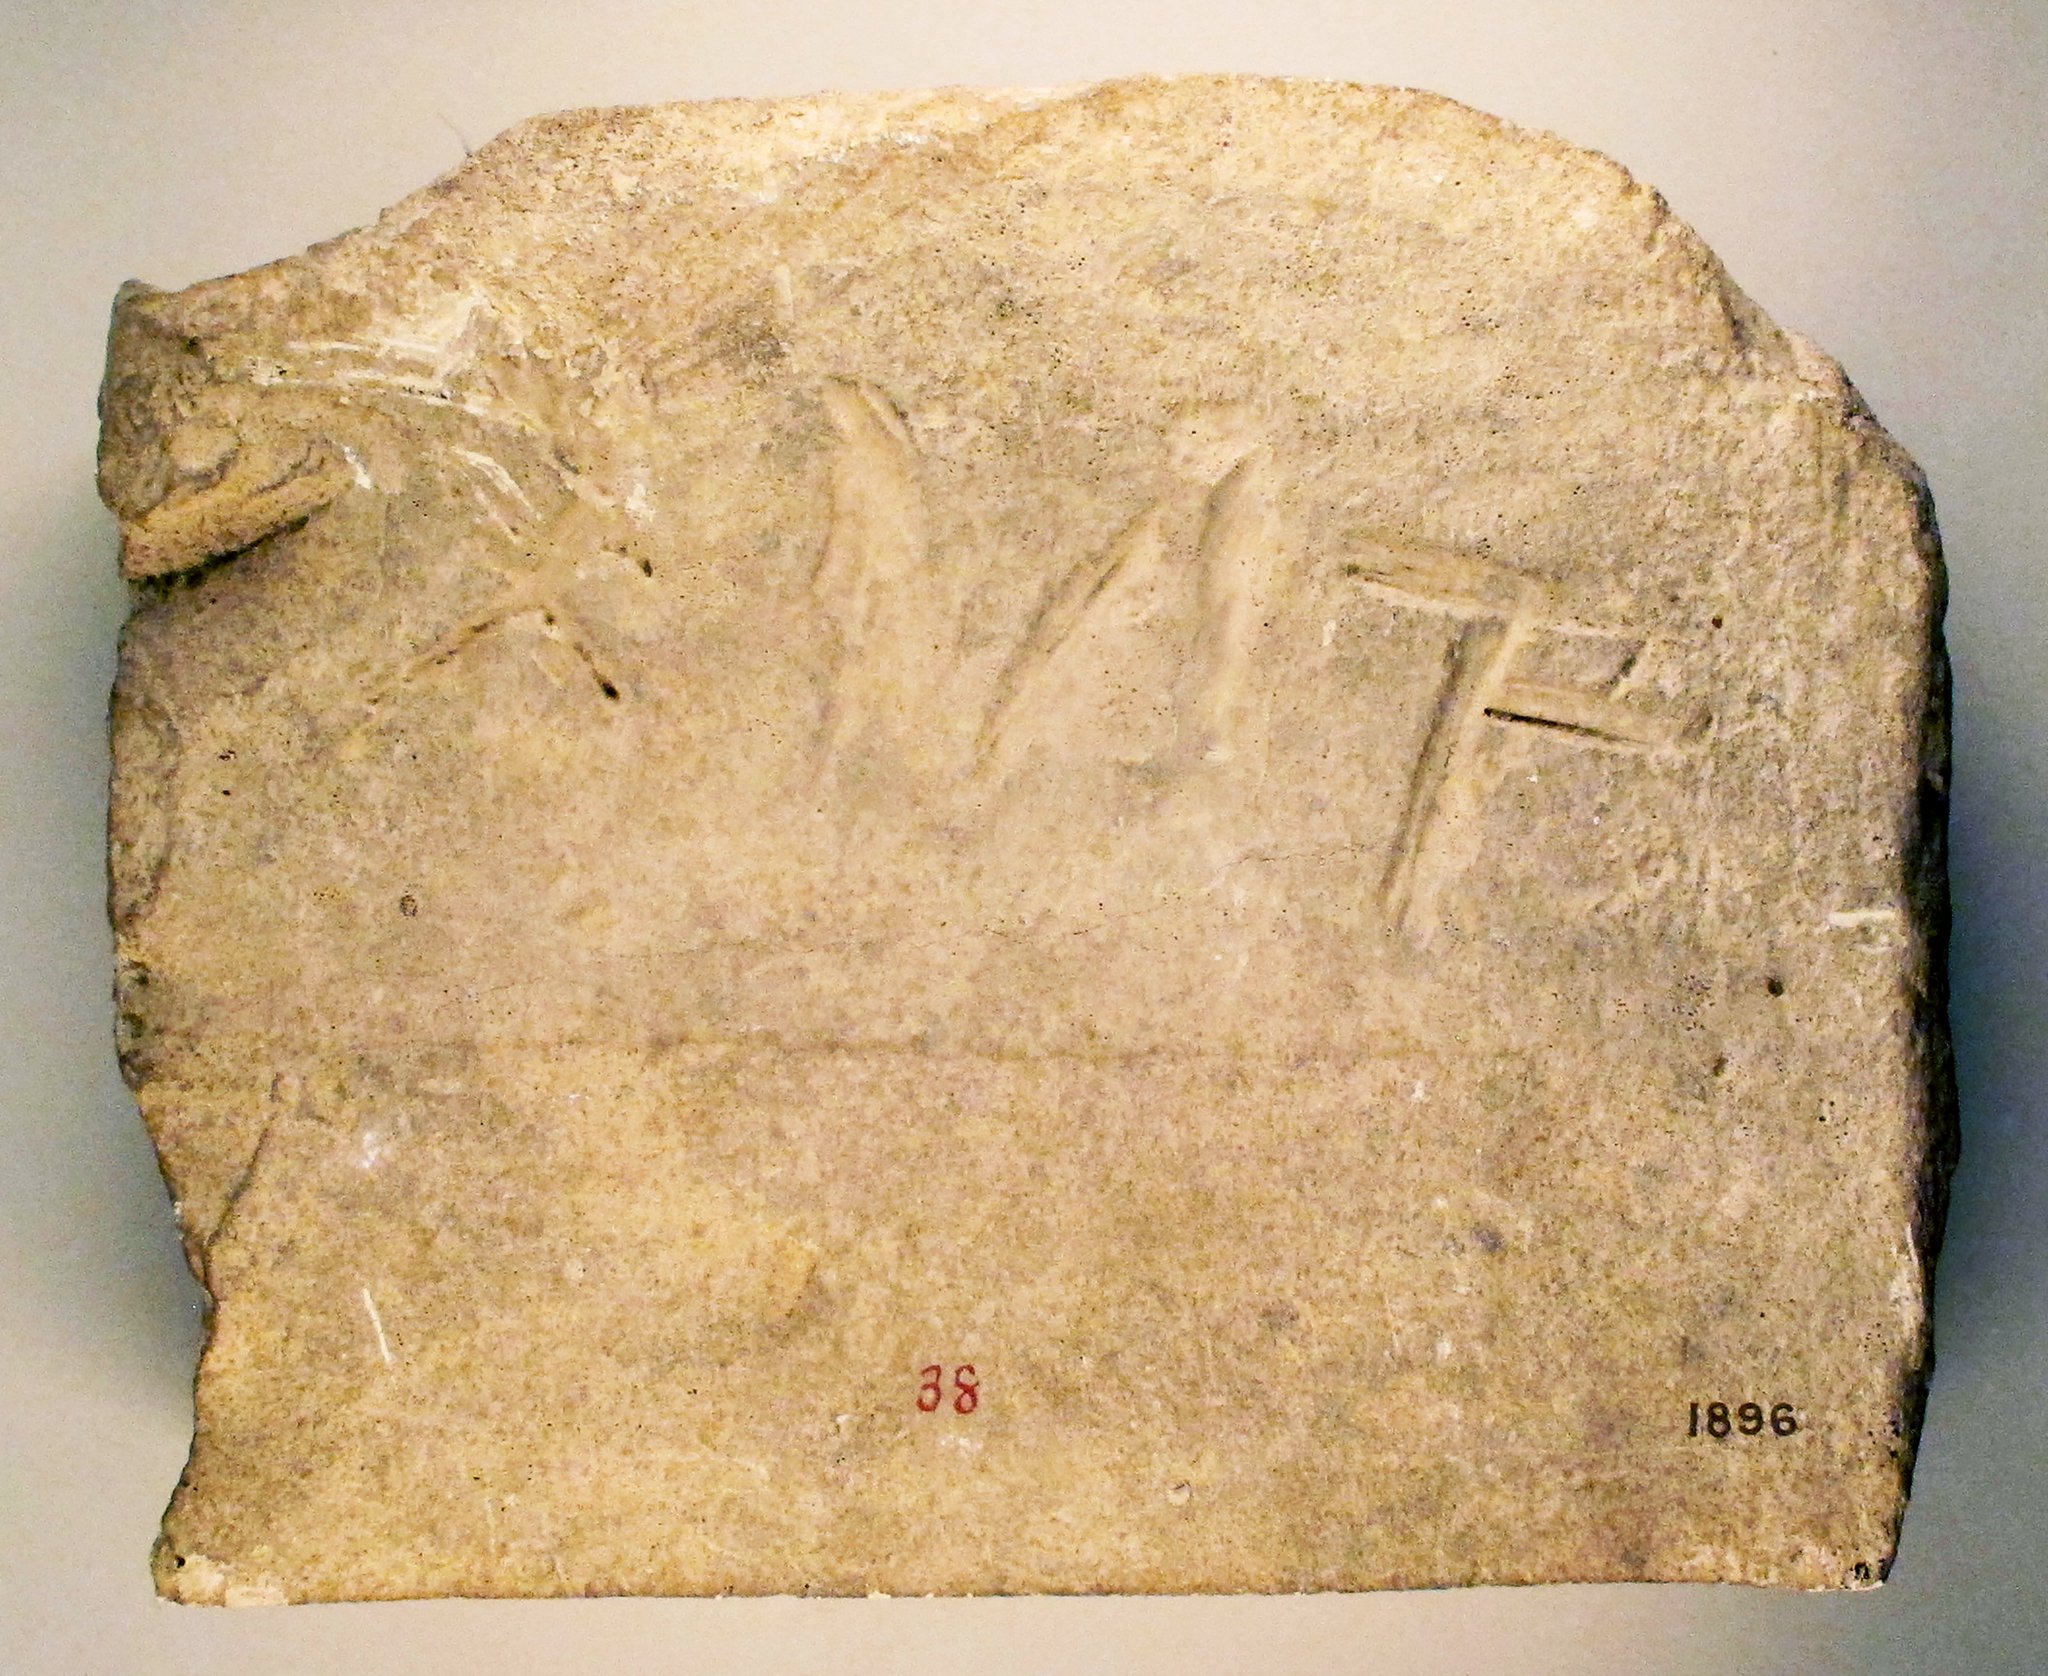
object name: block wall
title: Limestone inscribed block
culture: cypriot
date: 3900 BCE-100 CE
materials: limestone